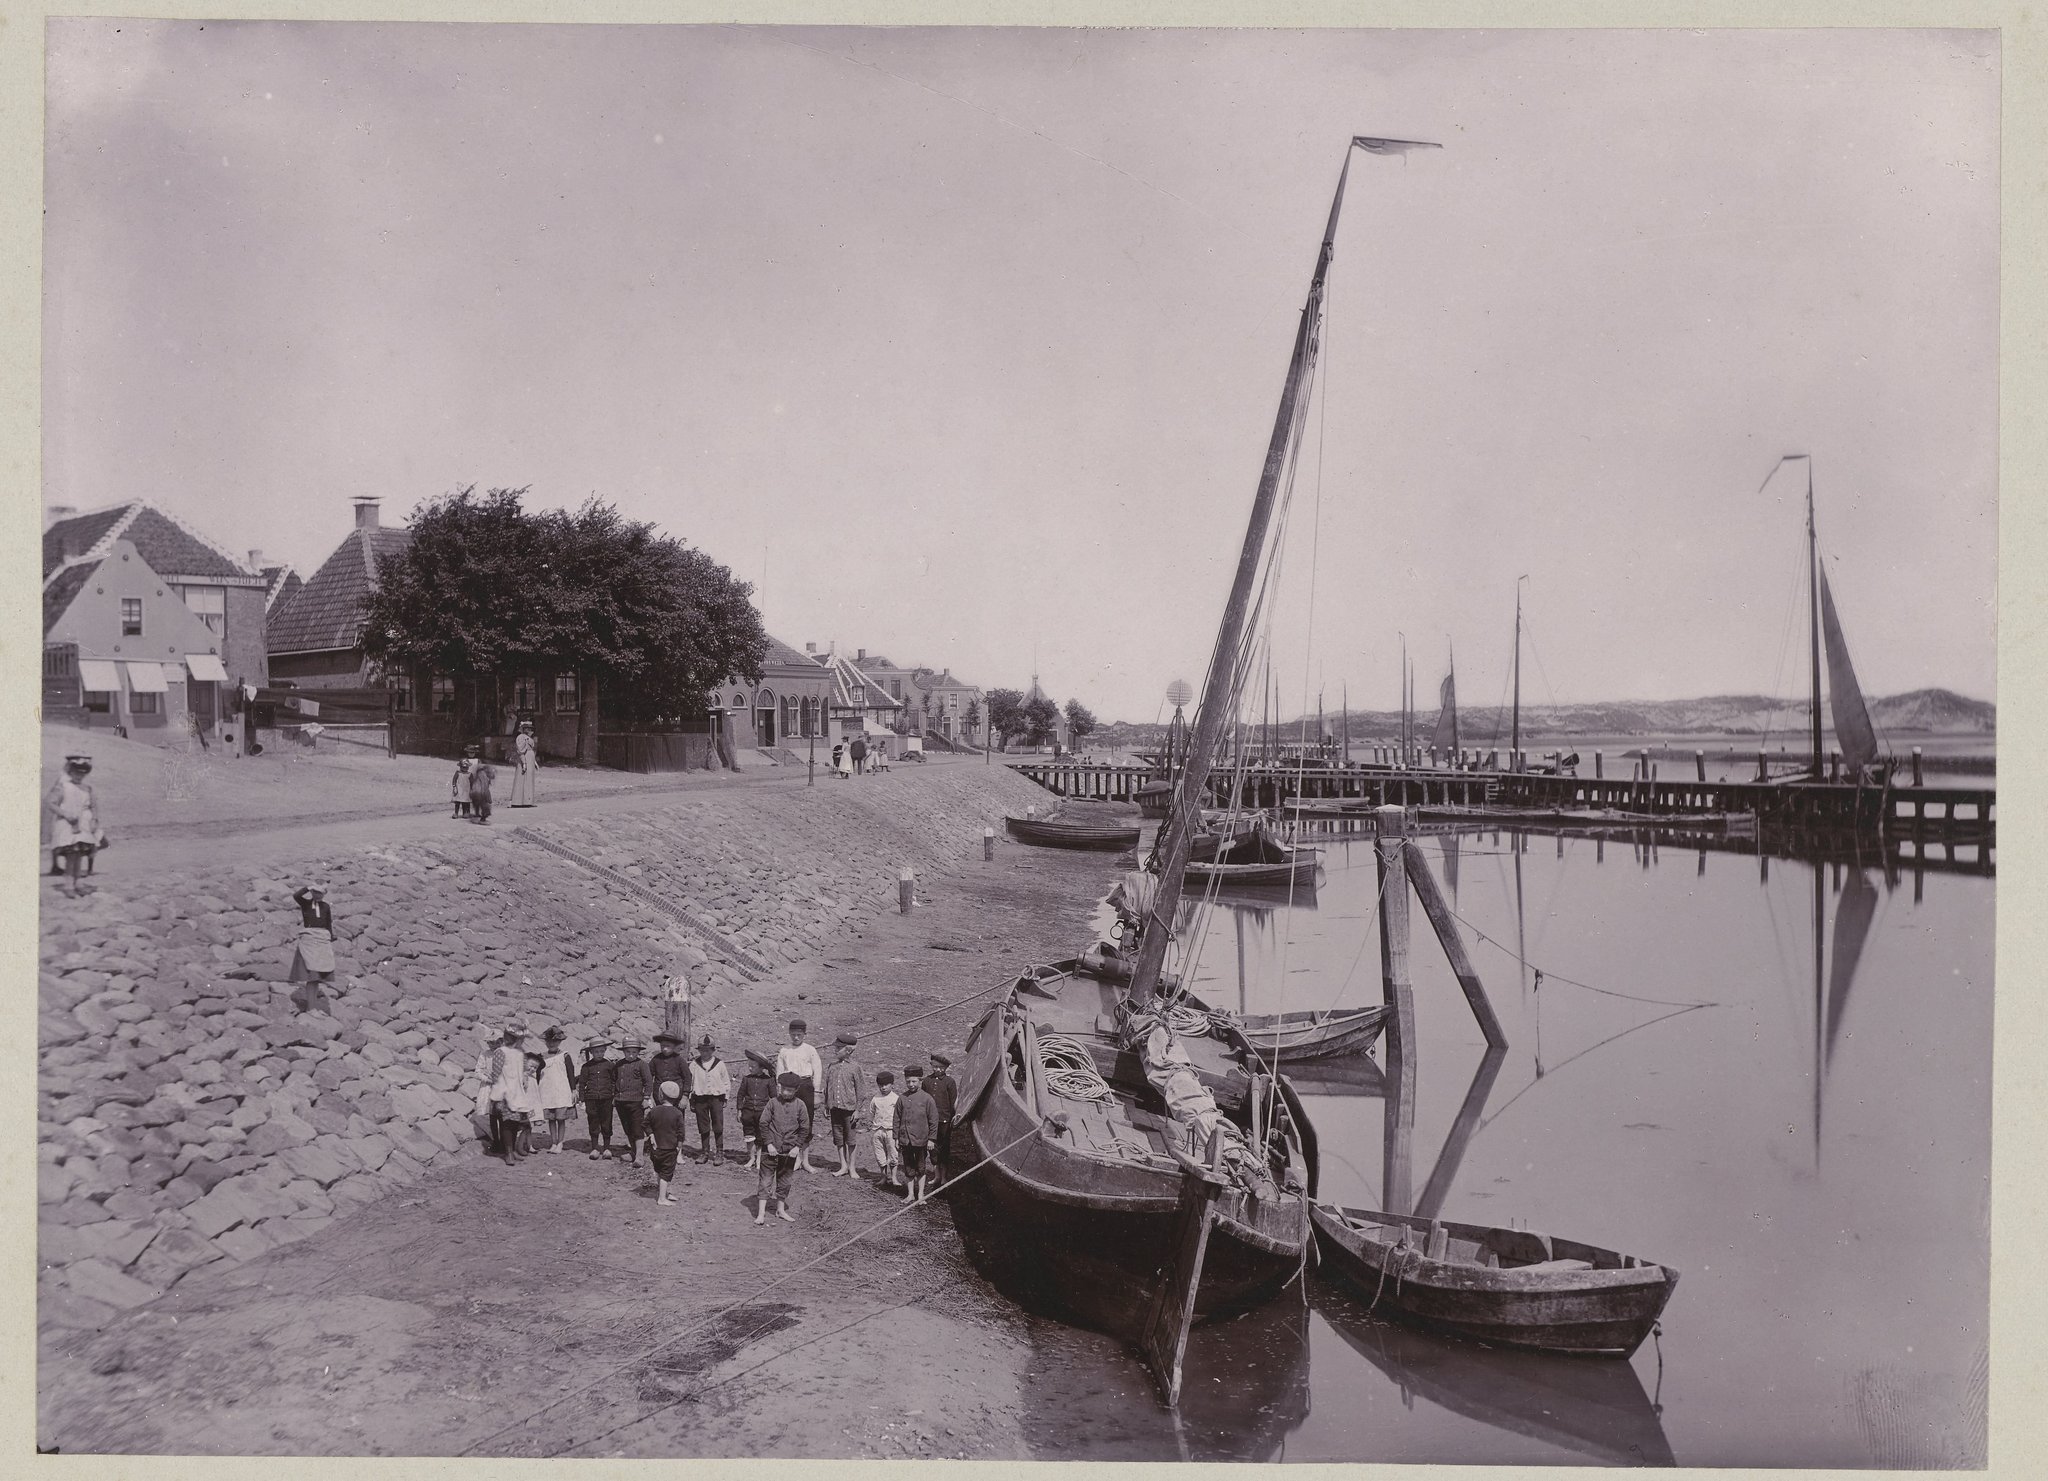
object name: photograph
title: Havengezicht op West-Terschelling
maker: frits freerks fontein fz.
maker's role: fotograaf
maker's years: 1882-1928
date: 1898-1915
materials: cardboard, paper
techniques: collodion silver print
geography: netherlands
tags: terschelling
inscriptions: inscription: ‘22.’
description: Los blad in album. Foto uit album 'Photographieën".